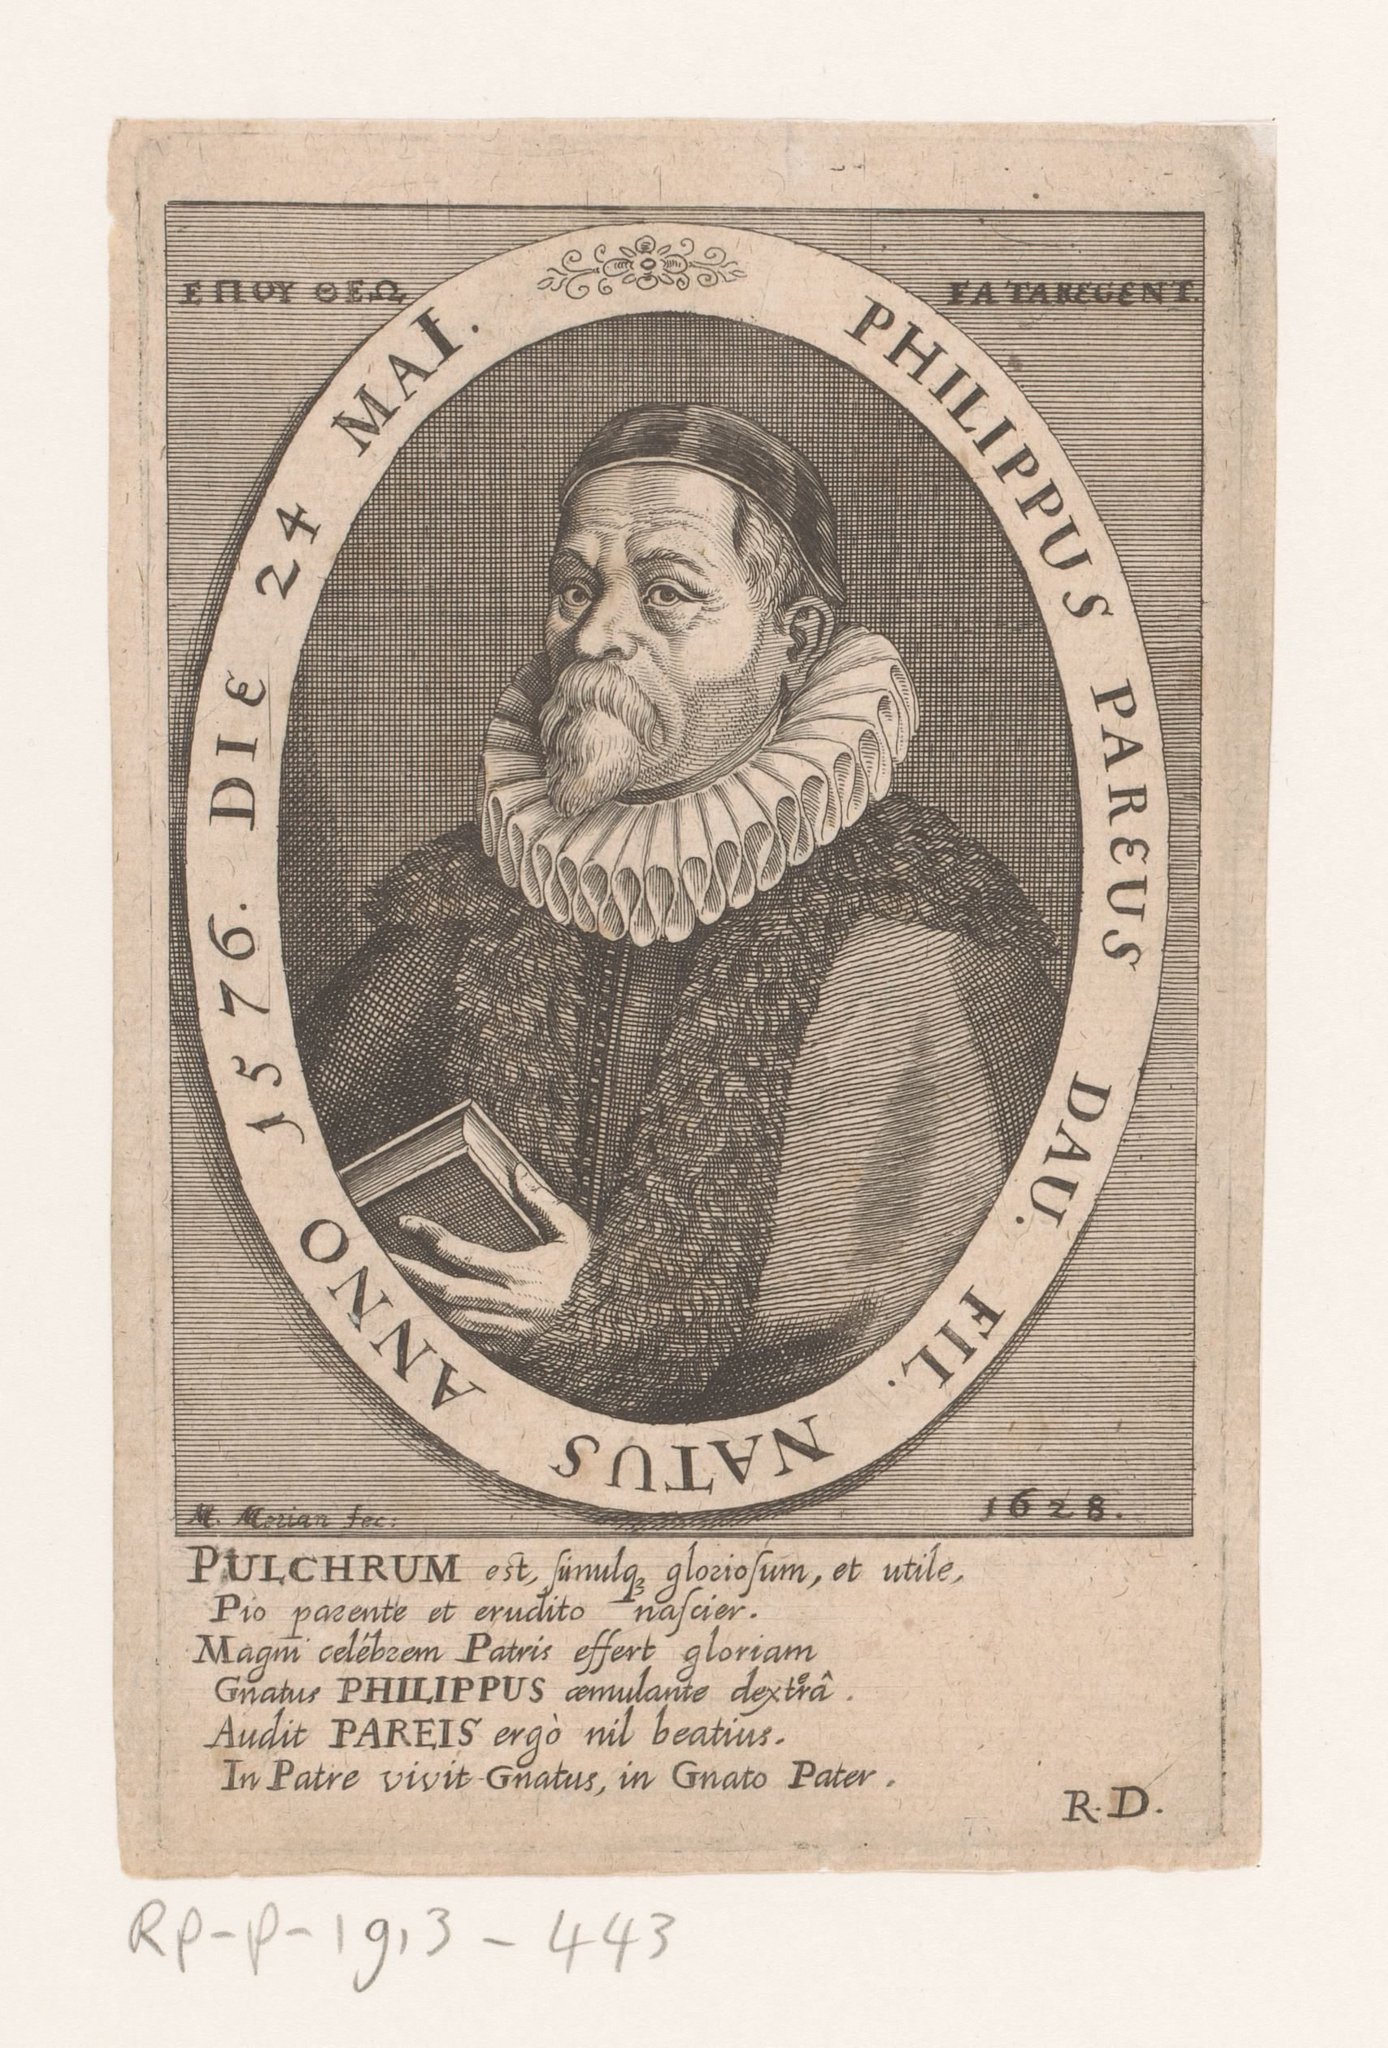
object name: print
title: Portret van Johannes Philippus Pareus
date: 1628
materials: paper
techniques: etching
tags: johannes philippus pareus, portrait of a writer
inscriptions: collector's mark: Lugt 2228